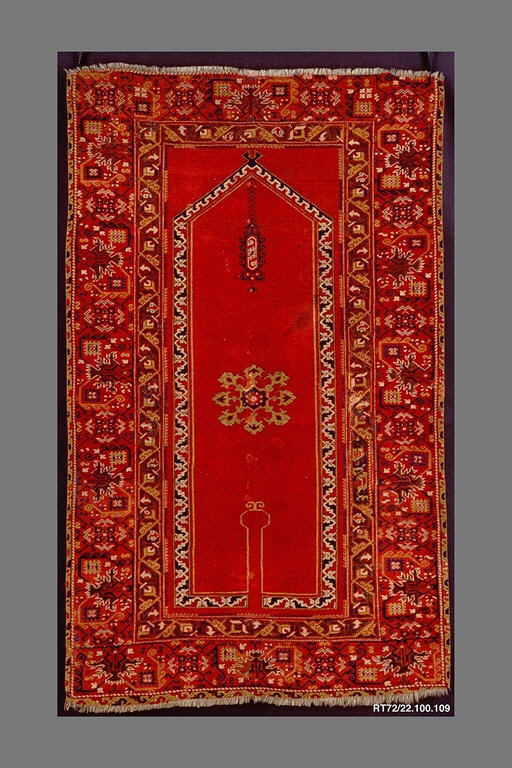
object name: carpet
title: 'Bellini' Carpet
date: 1501-1550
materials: wool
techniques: pile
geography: turkey